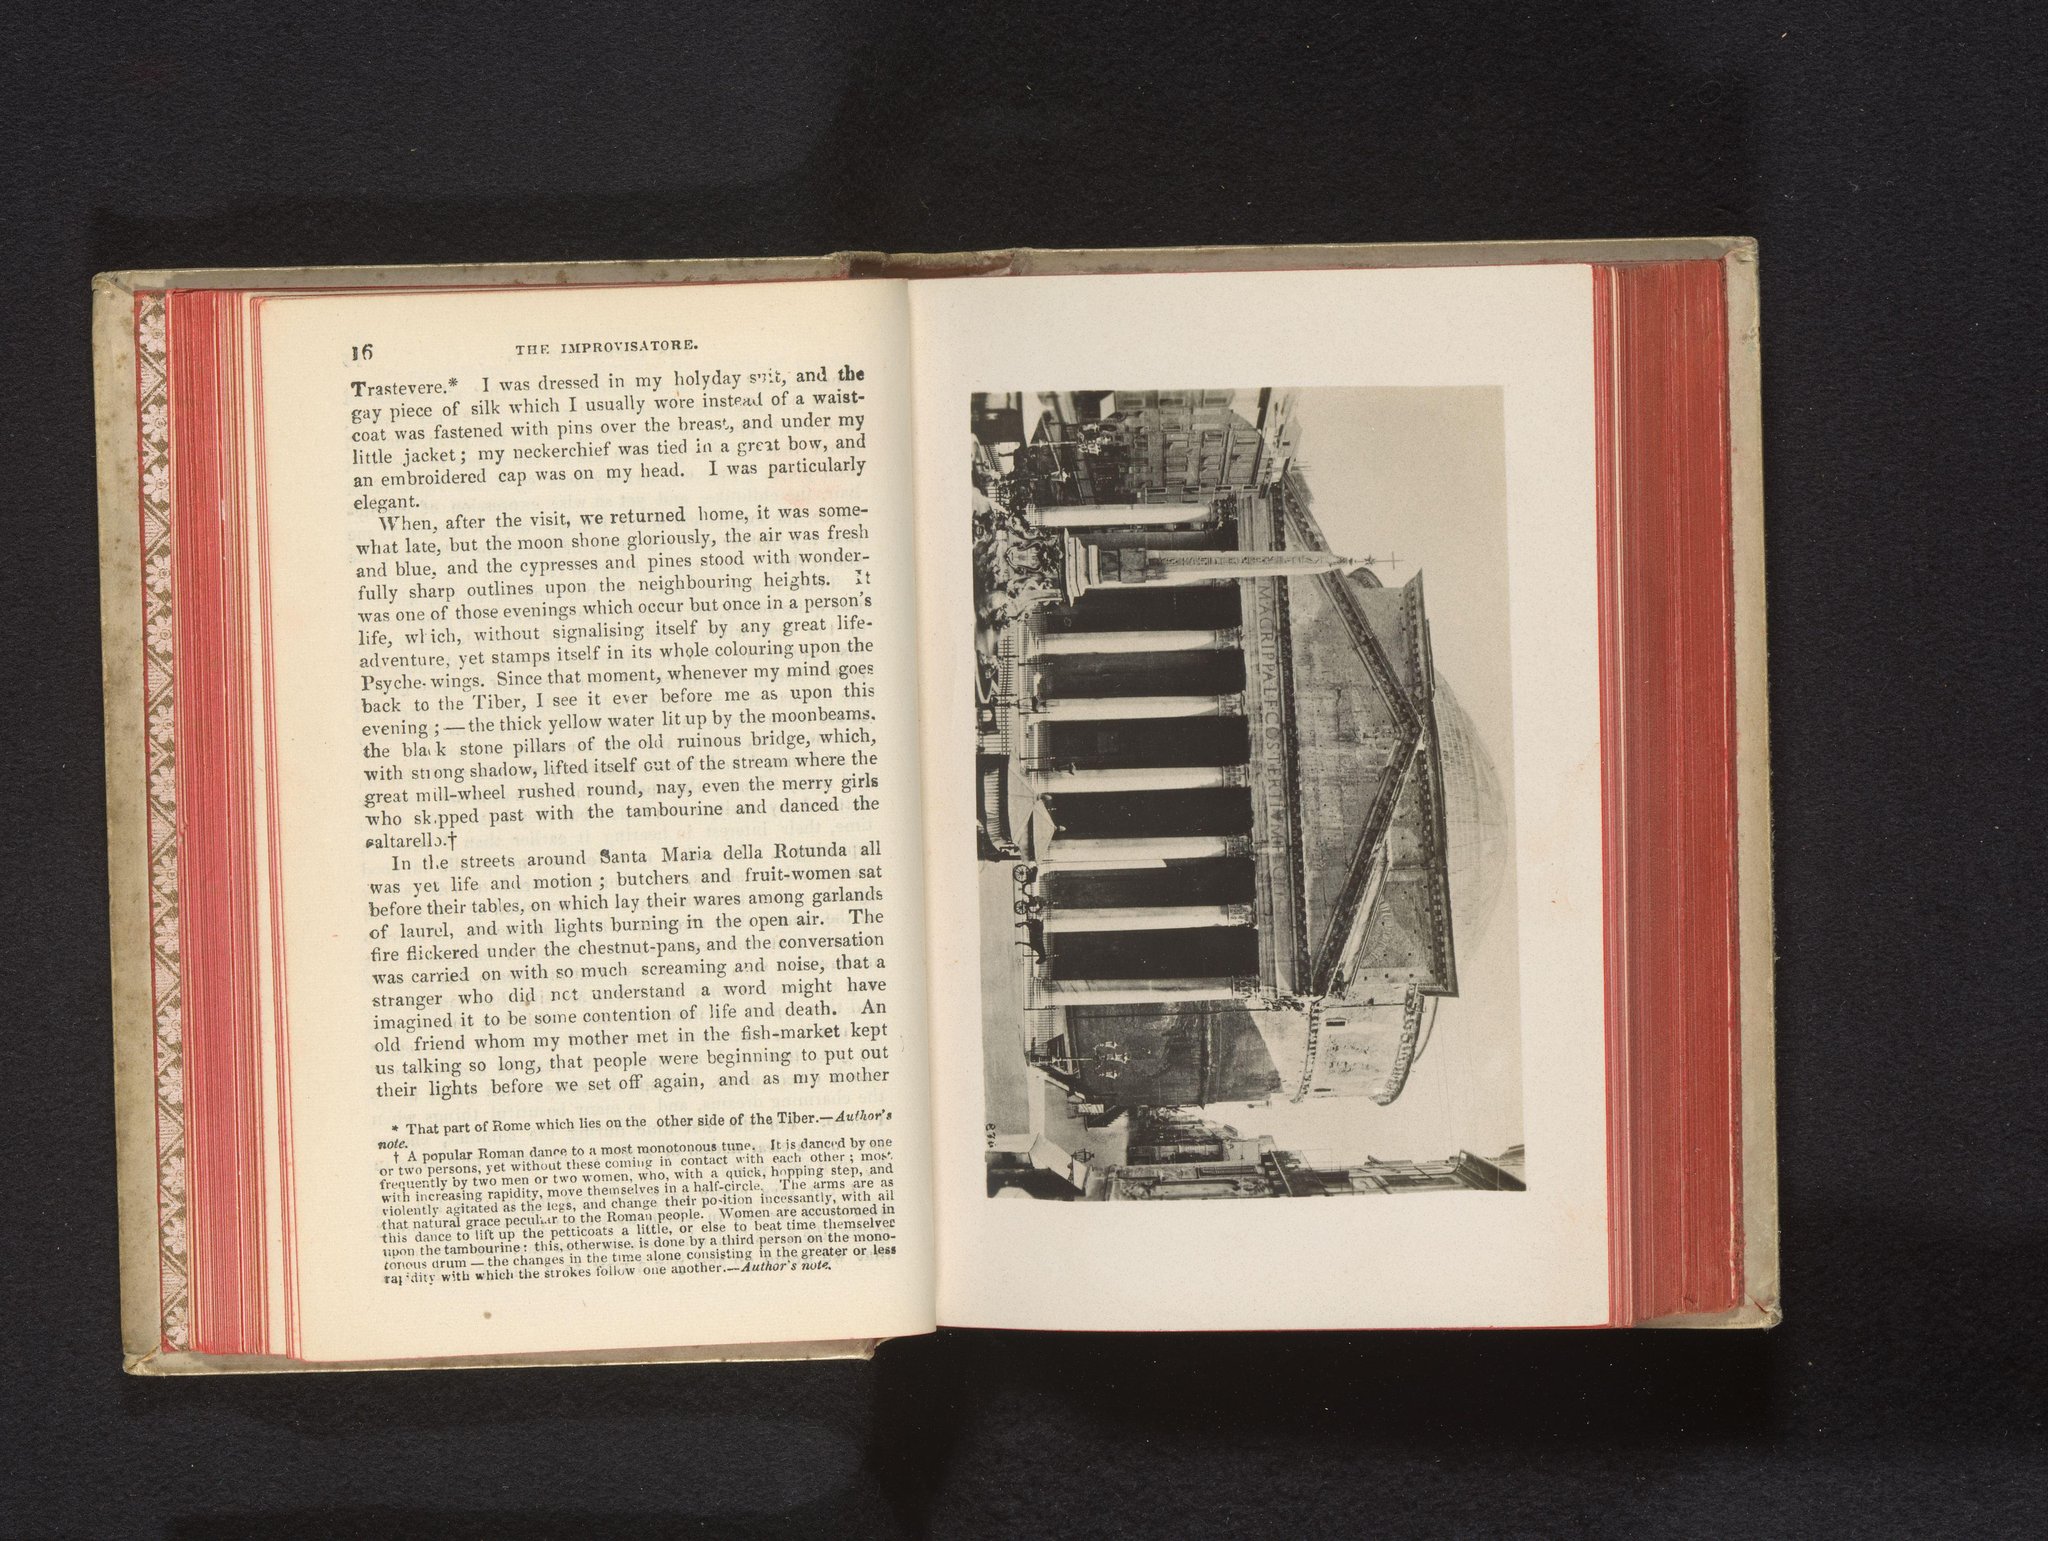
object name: photograph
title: Voorgevel van het Pantheon te Rome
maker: Anonymous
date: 1870-1880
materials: photographic support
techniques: gelatin silver print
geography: piazza della rotonda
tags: church (exterior), façade (of house or building)